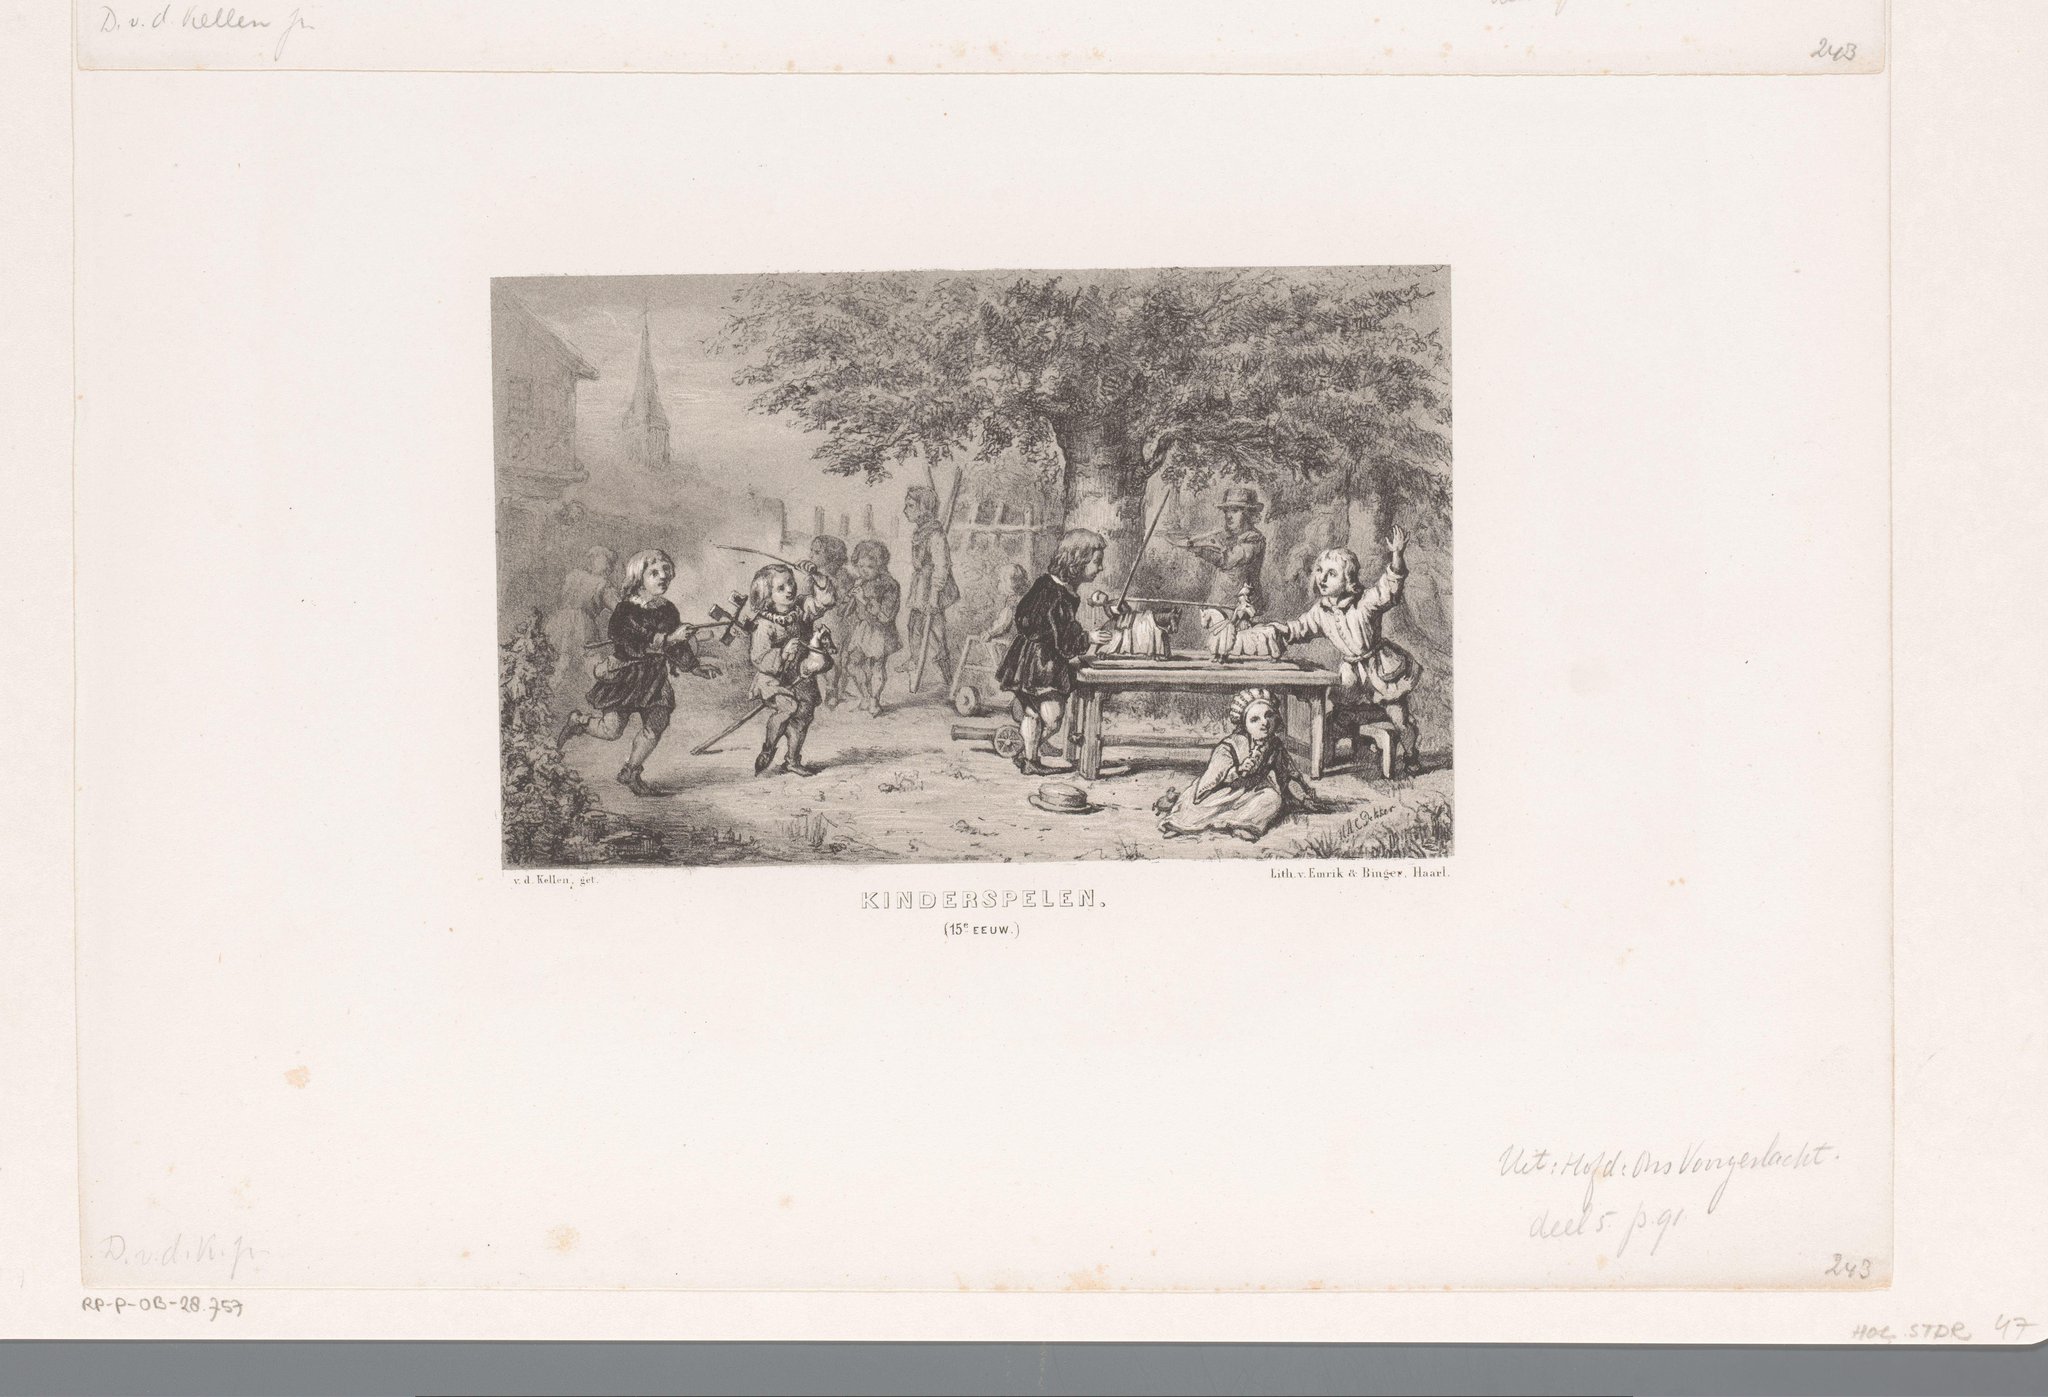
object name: print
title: Spelende kinderen in de vijftiende eeuw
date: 1859-1864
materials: paper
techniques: tone lithography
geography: haarlem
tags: children's games and plays, hobby-horse, (walking on) stilts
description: De kinderen spelen buiten. Op de tafel rechts spelen twee kinderen een steekspel na met paarden. Links rennen twee kinderen, een van hen heeft een stokpaard. In de achtergrond loopt een jongen op stelten.